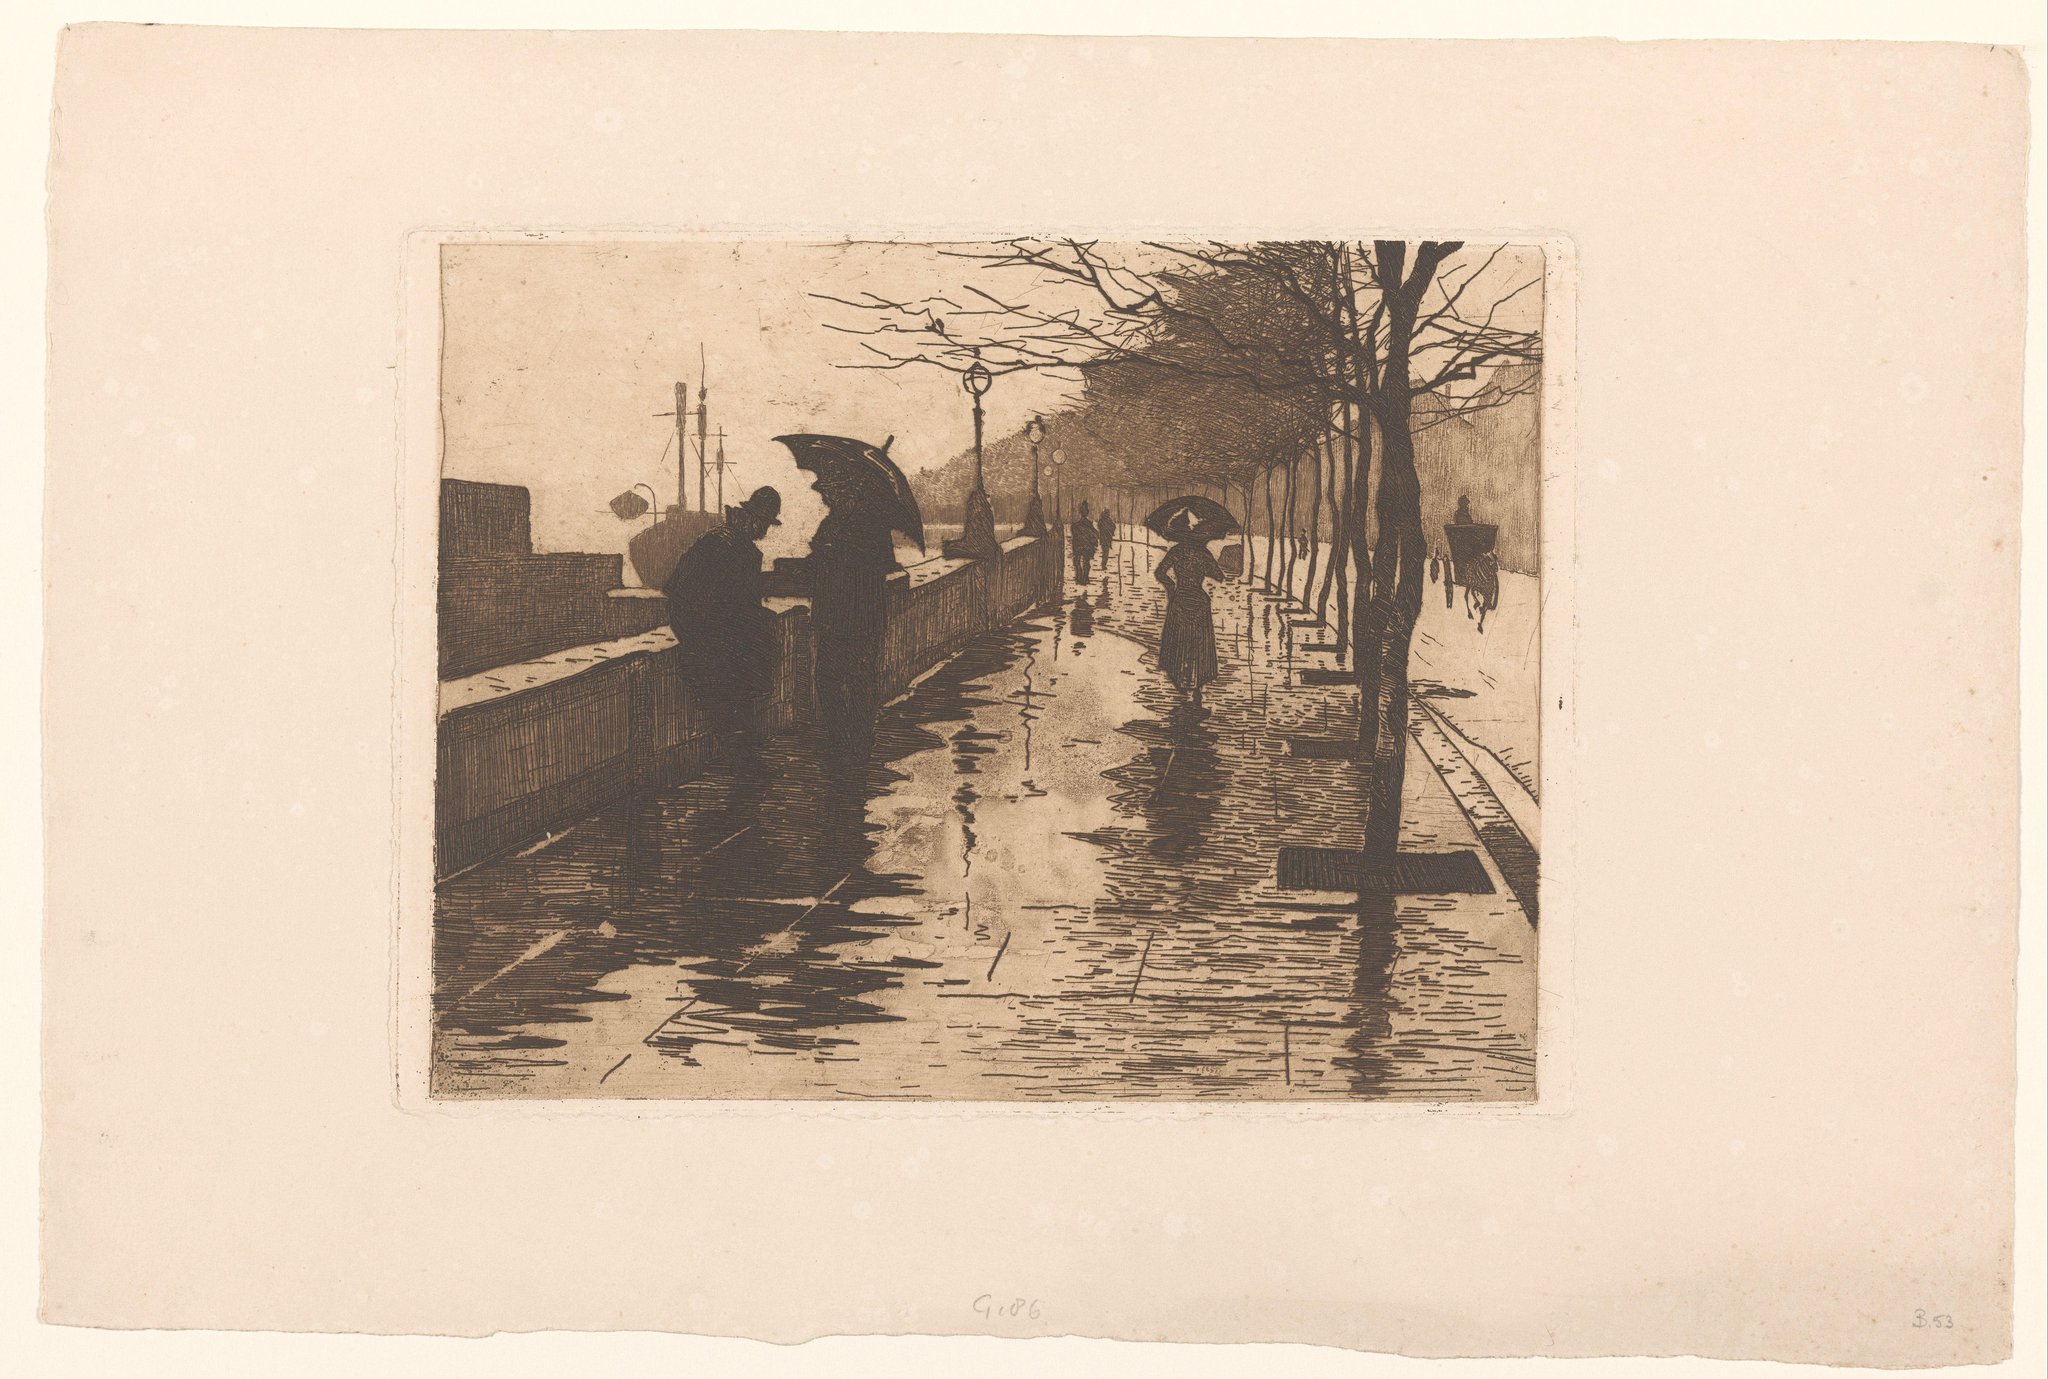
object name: print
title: Gezicht op Victoria Embankment in Londen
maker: willem witsen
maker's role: draughtsman, painter, print maker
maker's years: 1860-1923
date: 1890-1908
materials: paper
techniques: aquatint, etching, intaglio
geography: london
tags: city-view in general; 'veduta', river, public road, thames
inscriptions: collector's mark: Lugt 2228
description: Een rijtuig en wandelaars in de regen. Links een schip in de Theems.